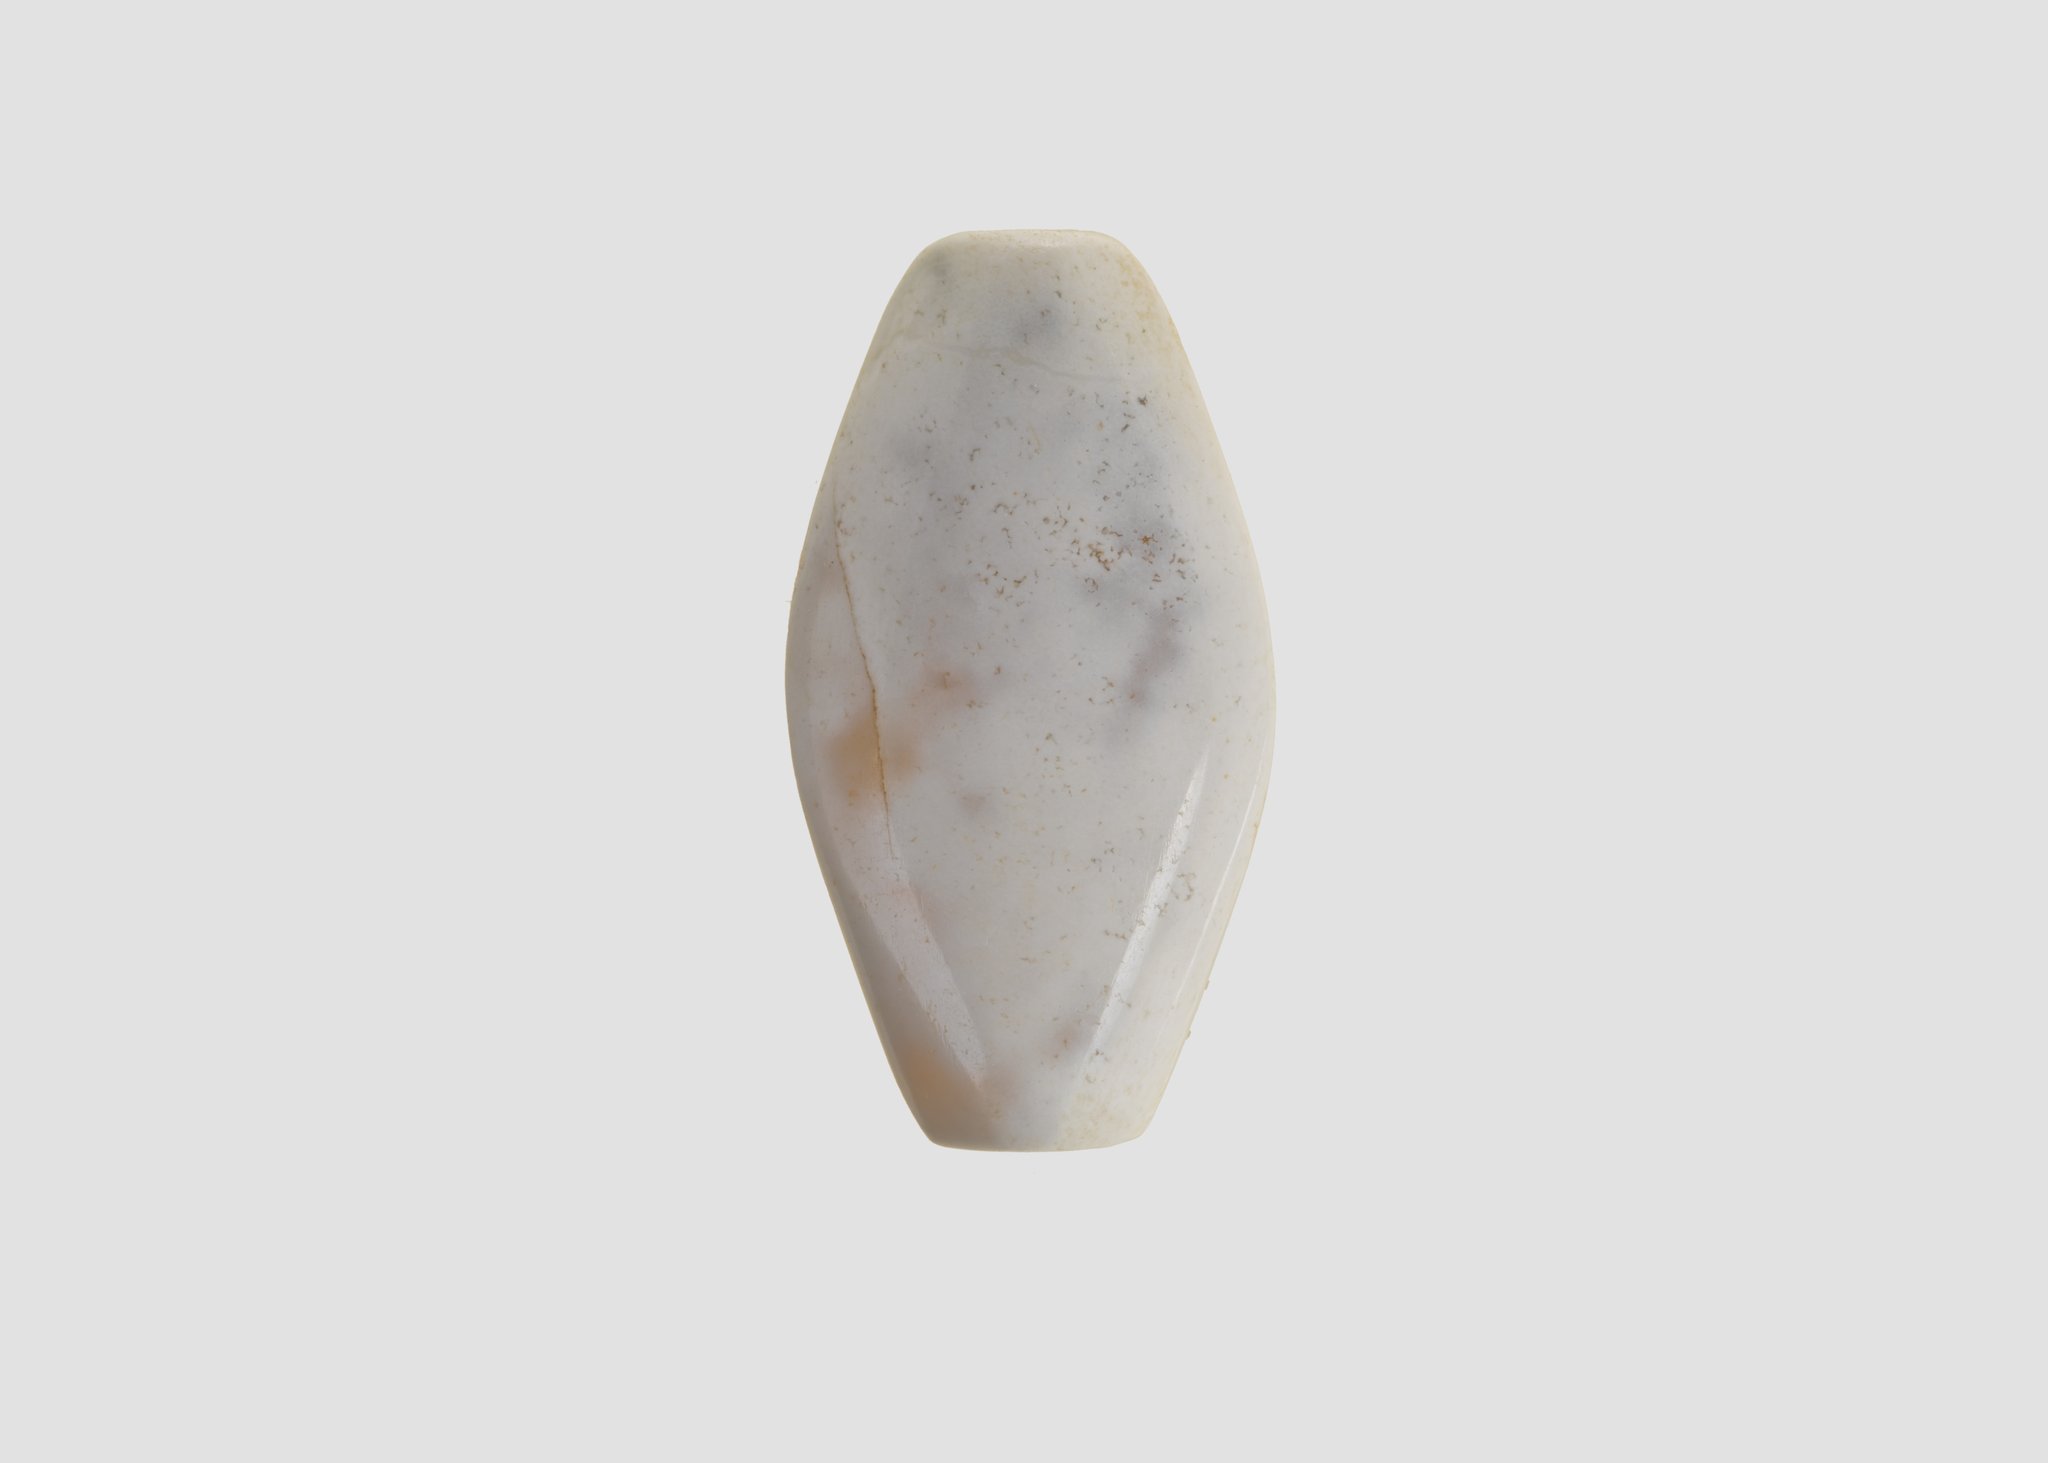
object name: bead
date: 7000-5001 BCE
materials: stone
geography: syria